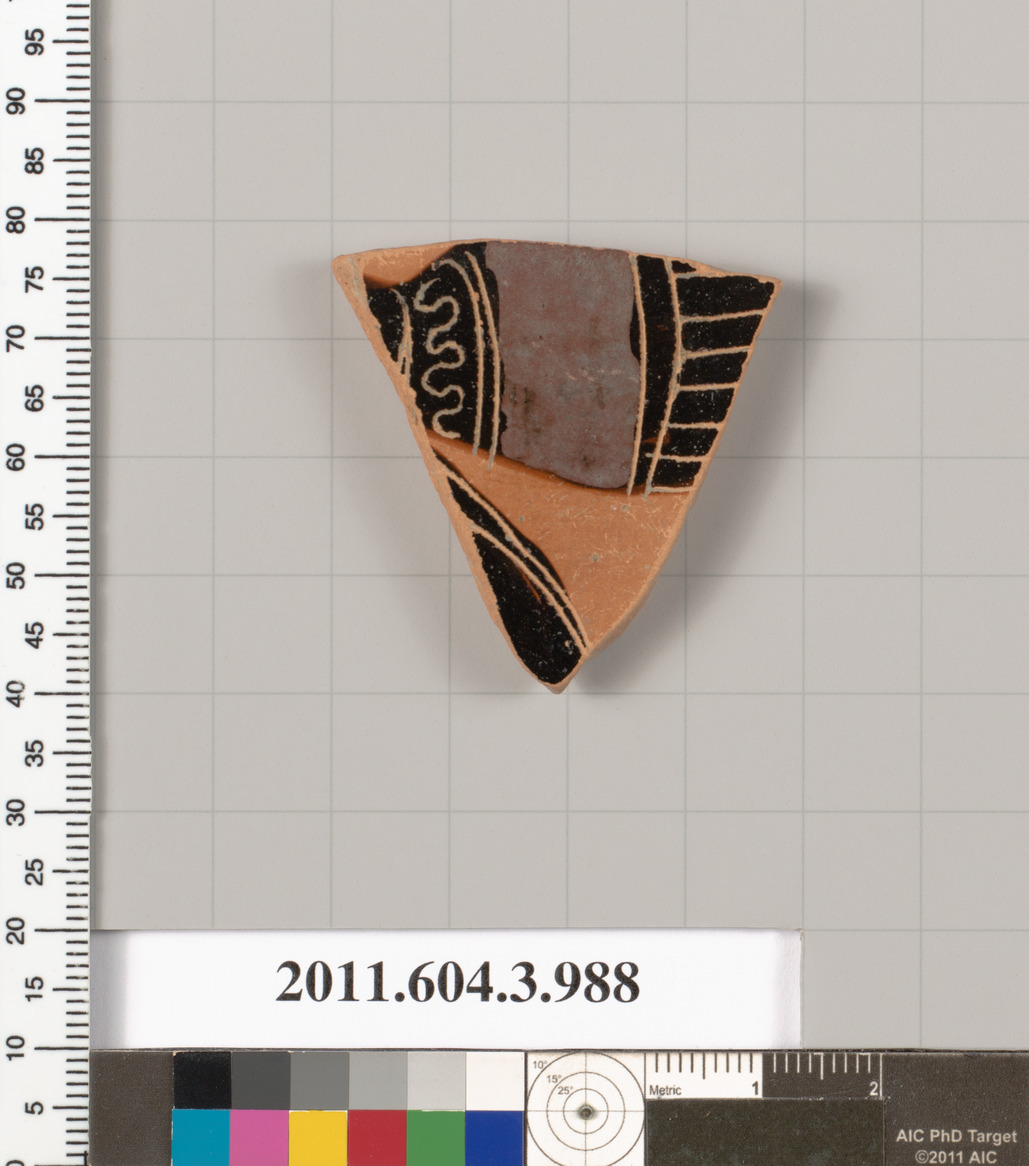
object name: lekanis lid fragment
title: Terracotta fragment of a lekanis lid (covered dish)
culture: greek, attic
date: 575-551 BCE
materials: terracotta